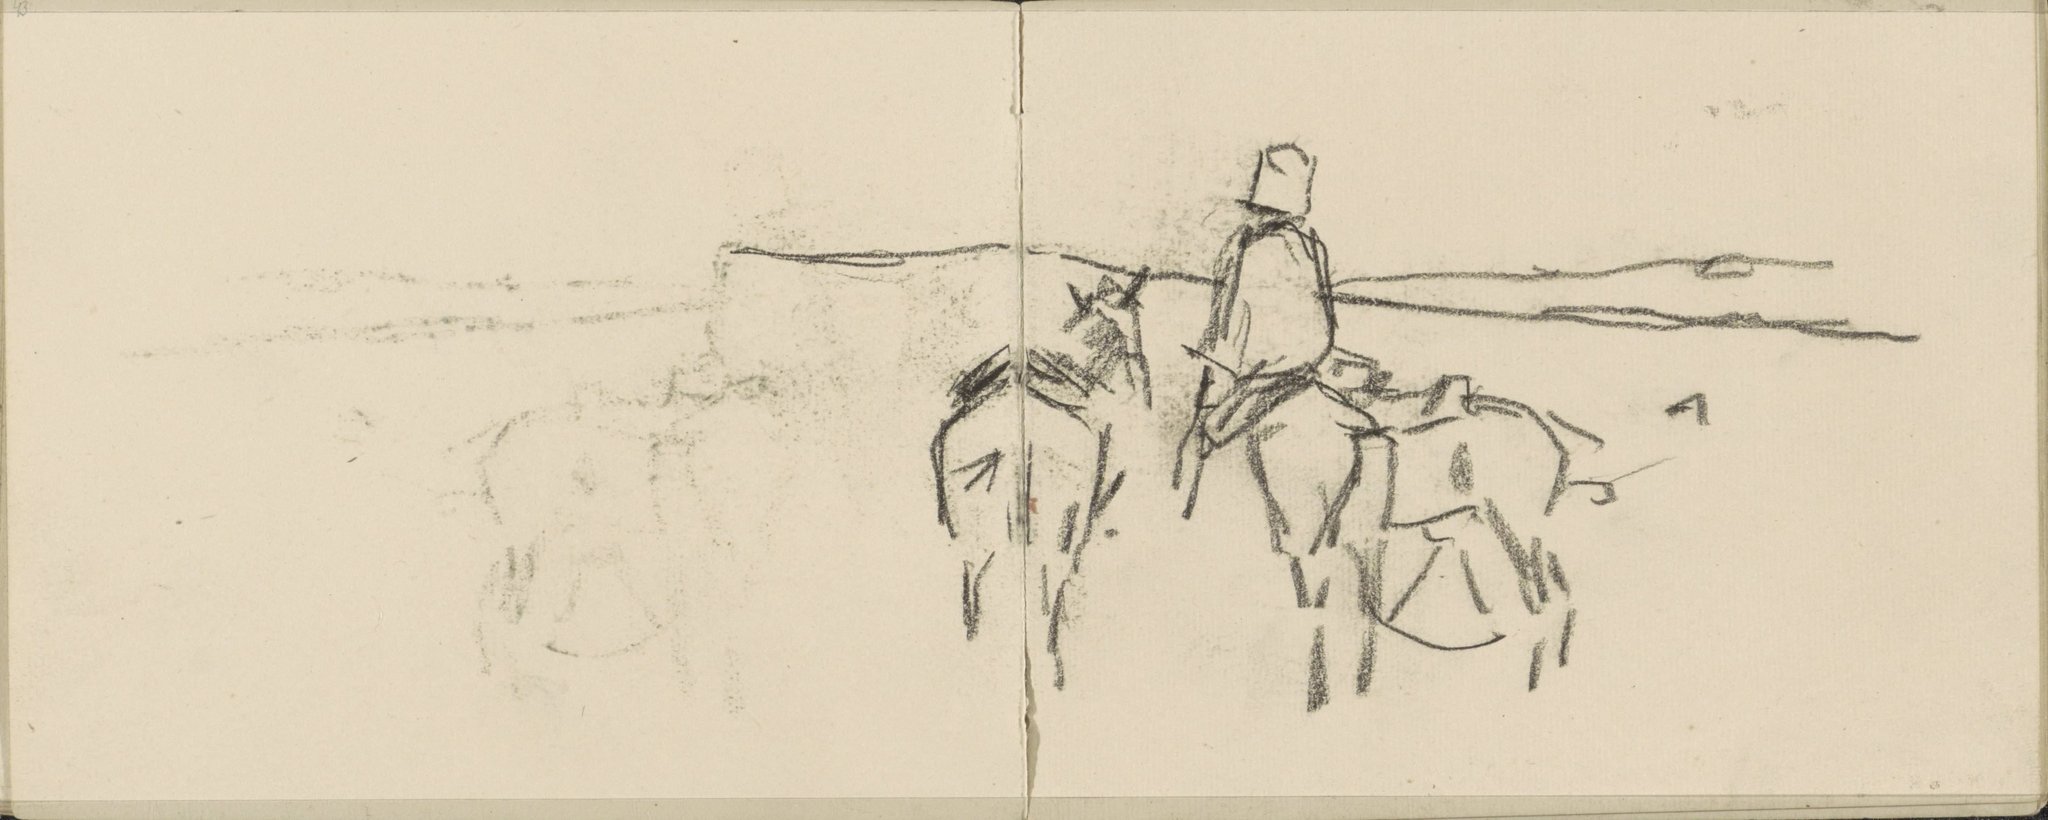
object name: sketchbook leaf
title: Ruiter met paarden op de Lemelerberg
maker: george hendrik breitner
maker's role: draughtsman, painter, print maker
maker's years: 1857-1923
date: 1885-1898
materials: chalk, paper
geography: ommen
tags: horse, the soldier; the soldier's life (+ cavalry, horsemen)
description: Pagina 43 en pagina 44 uit een schetsboek met 32 bladen.